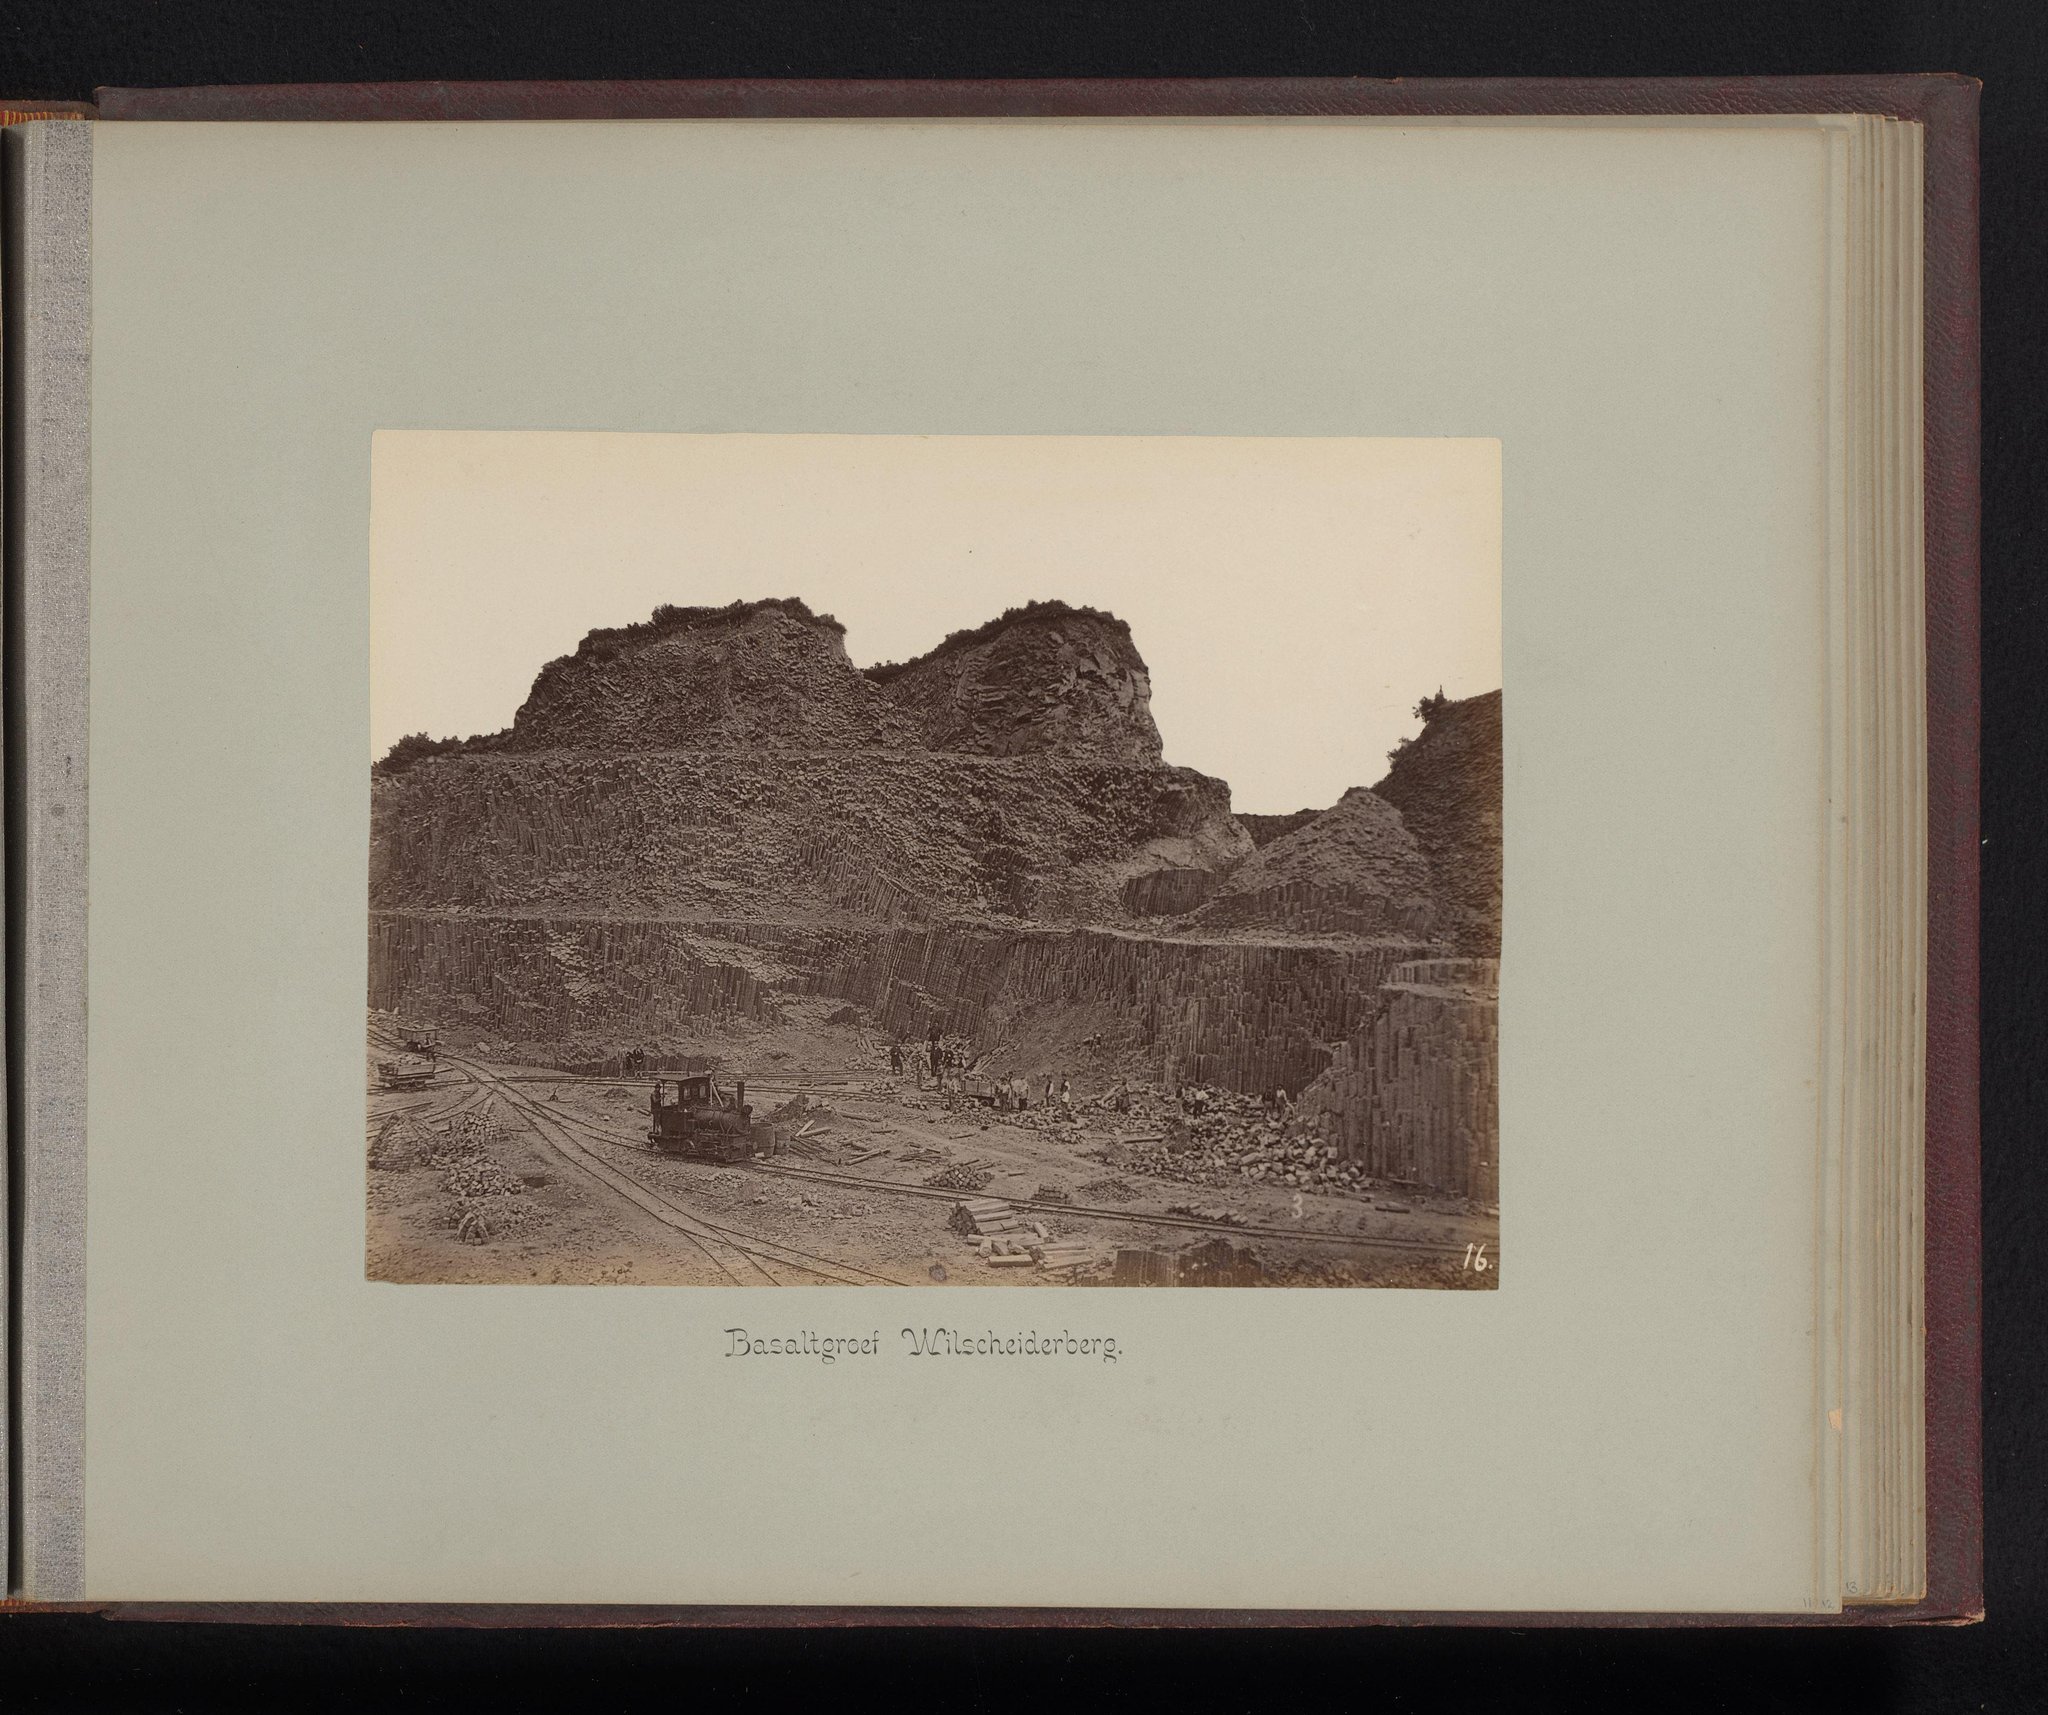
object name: photograph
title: Gezicht op de basaltgroeve Wilscheiderberg in Noord-Rijnland-Westfalen, Duitsland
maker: Anonymous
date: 1883-1900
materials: cardboard, photographic support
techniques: albumen print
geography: north rhine-westphalia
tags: quarry (+ stone), quarry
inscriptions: number: ‘16.’